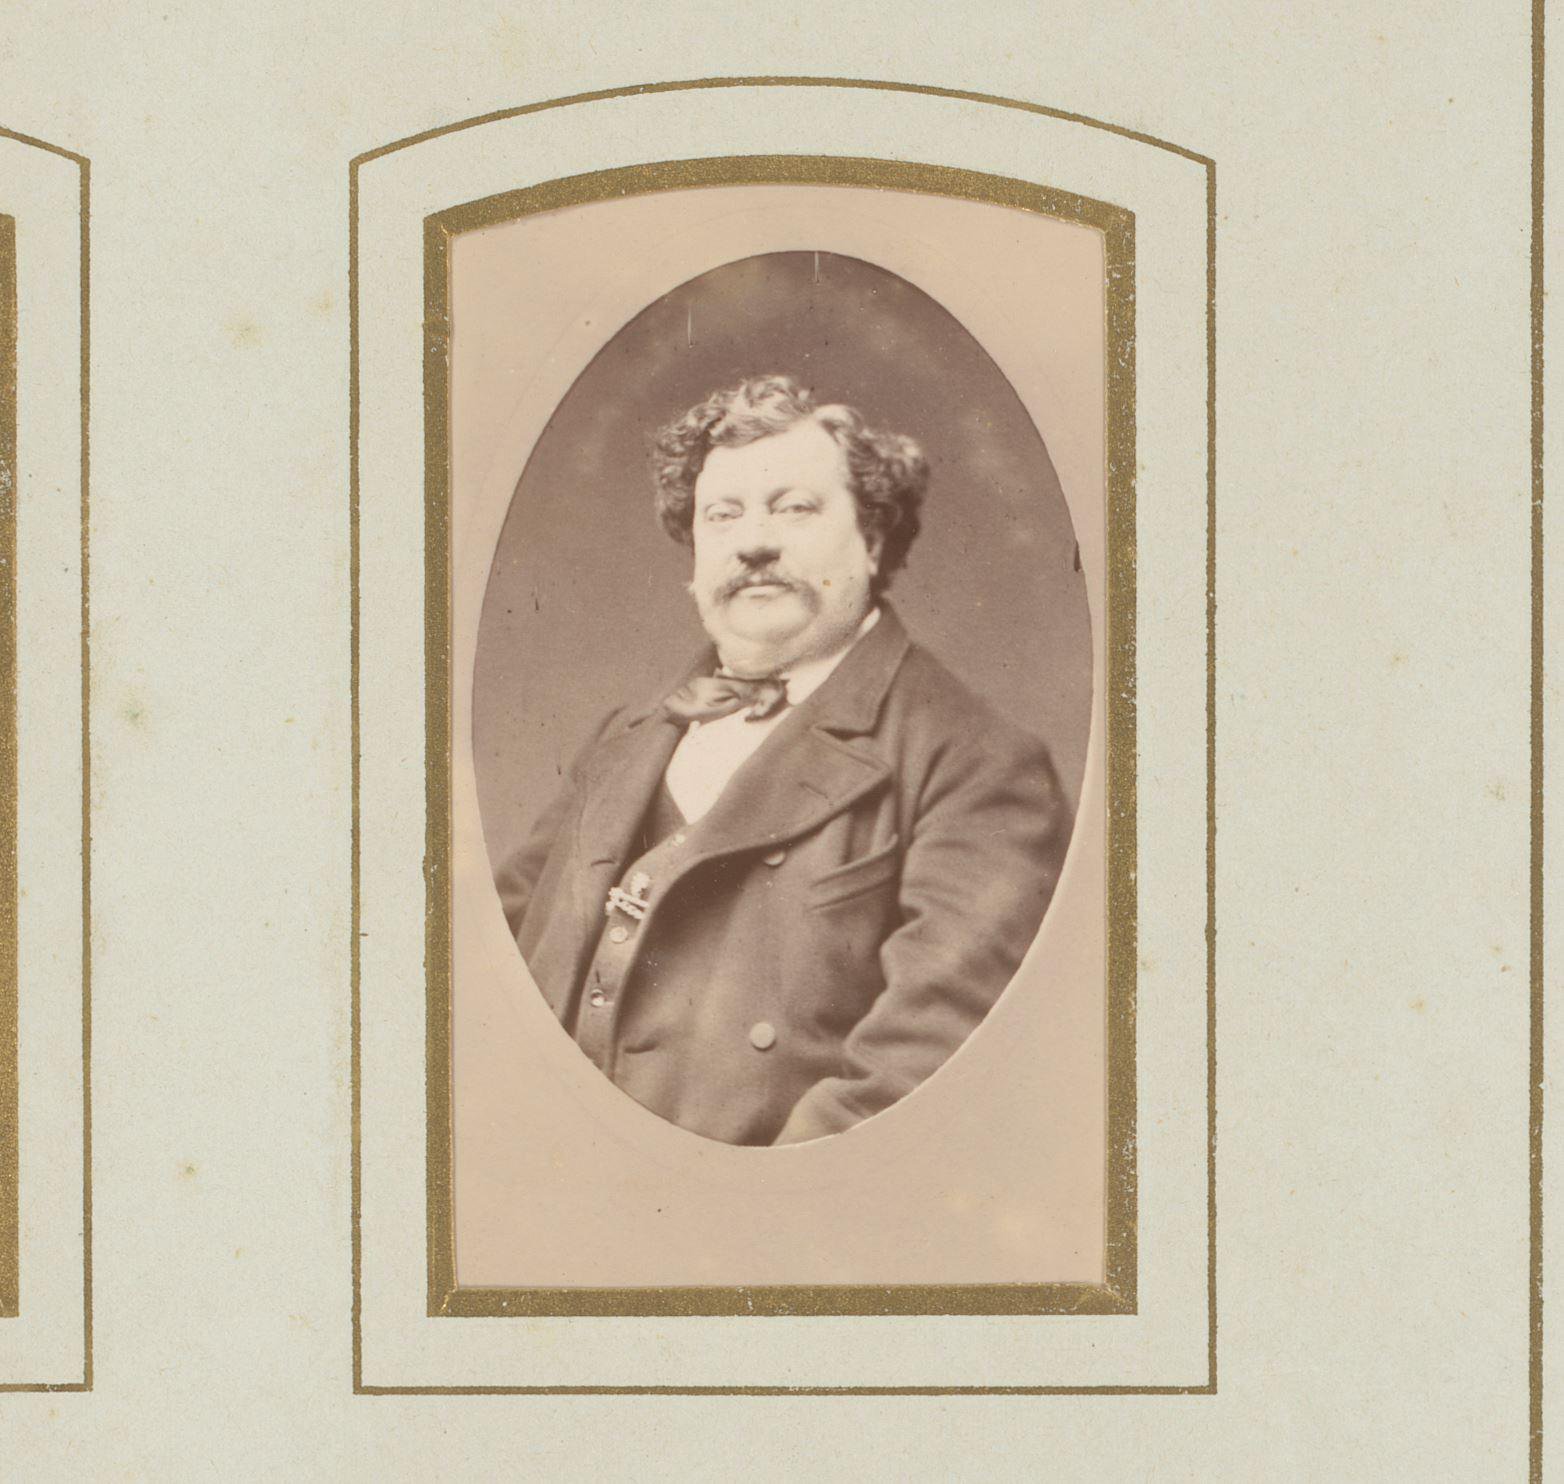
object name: semi enamel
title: Portret van een man met snor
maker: angelina trouillet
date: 1880-1900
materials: cardboard, celluloid, photographic support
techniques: albumen print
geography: paris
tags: moustache, historical persons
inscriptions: inscription: ‘Mme. Angelina Trouillet/ PHOTOGRAPHE DE LA SOCIÉTÉ NATIONALE/ D'ENCOURAGEMENT AU BIEN/ 16, Rue d'Arcet/ Ancienne Rue du Boulevard/ PARIS-BATIGNOLLES/ Spécialité pour les Reproductions/ et les Portraits d'Enfants’